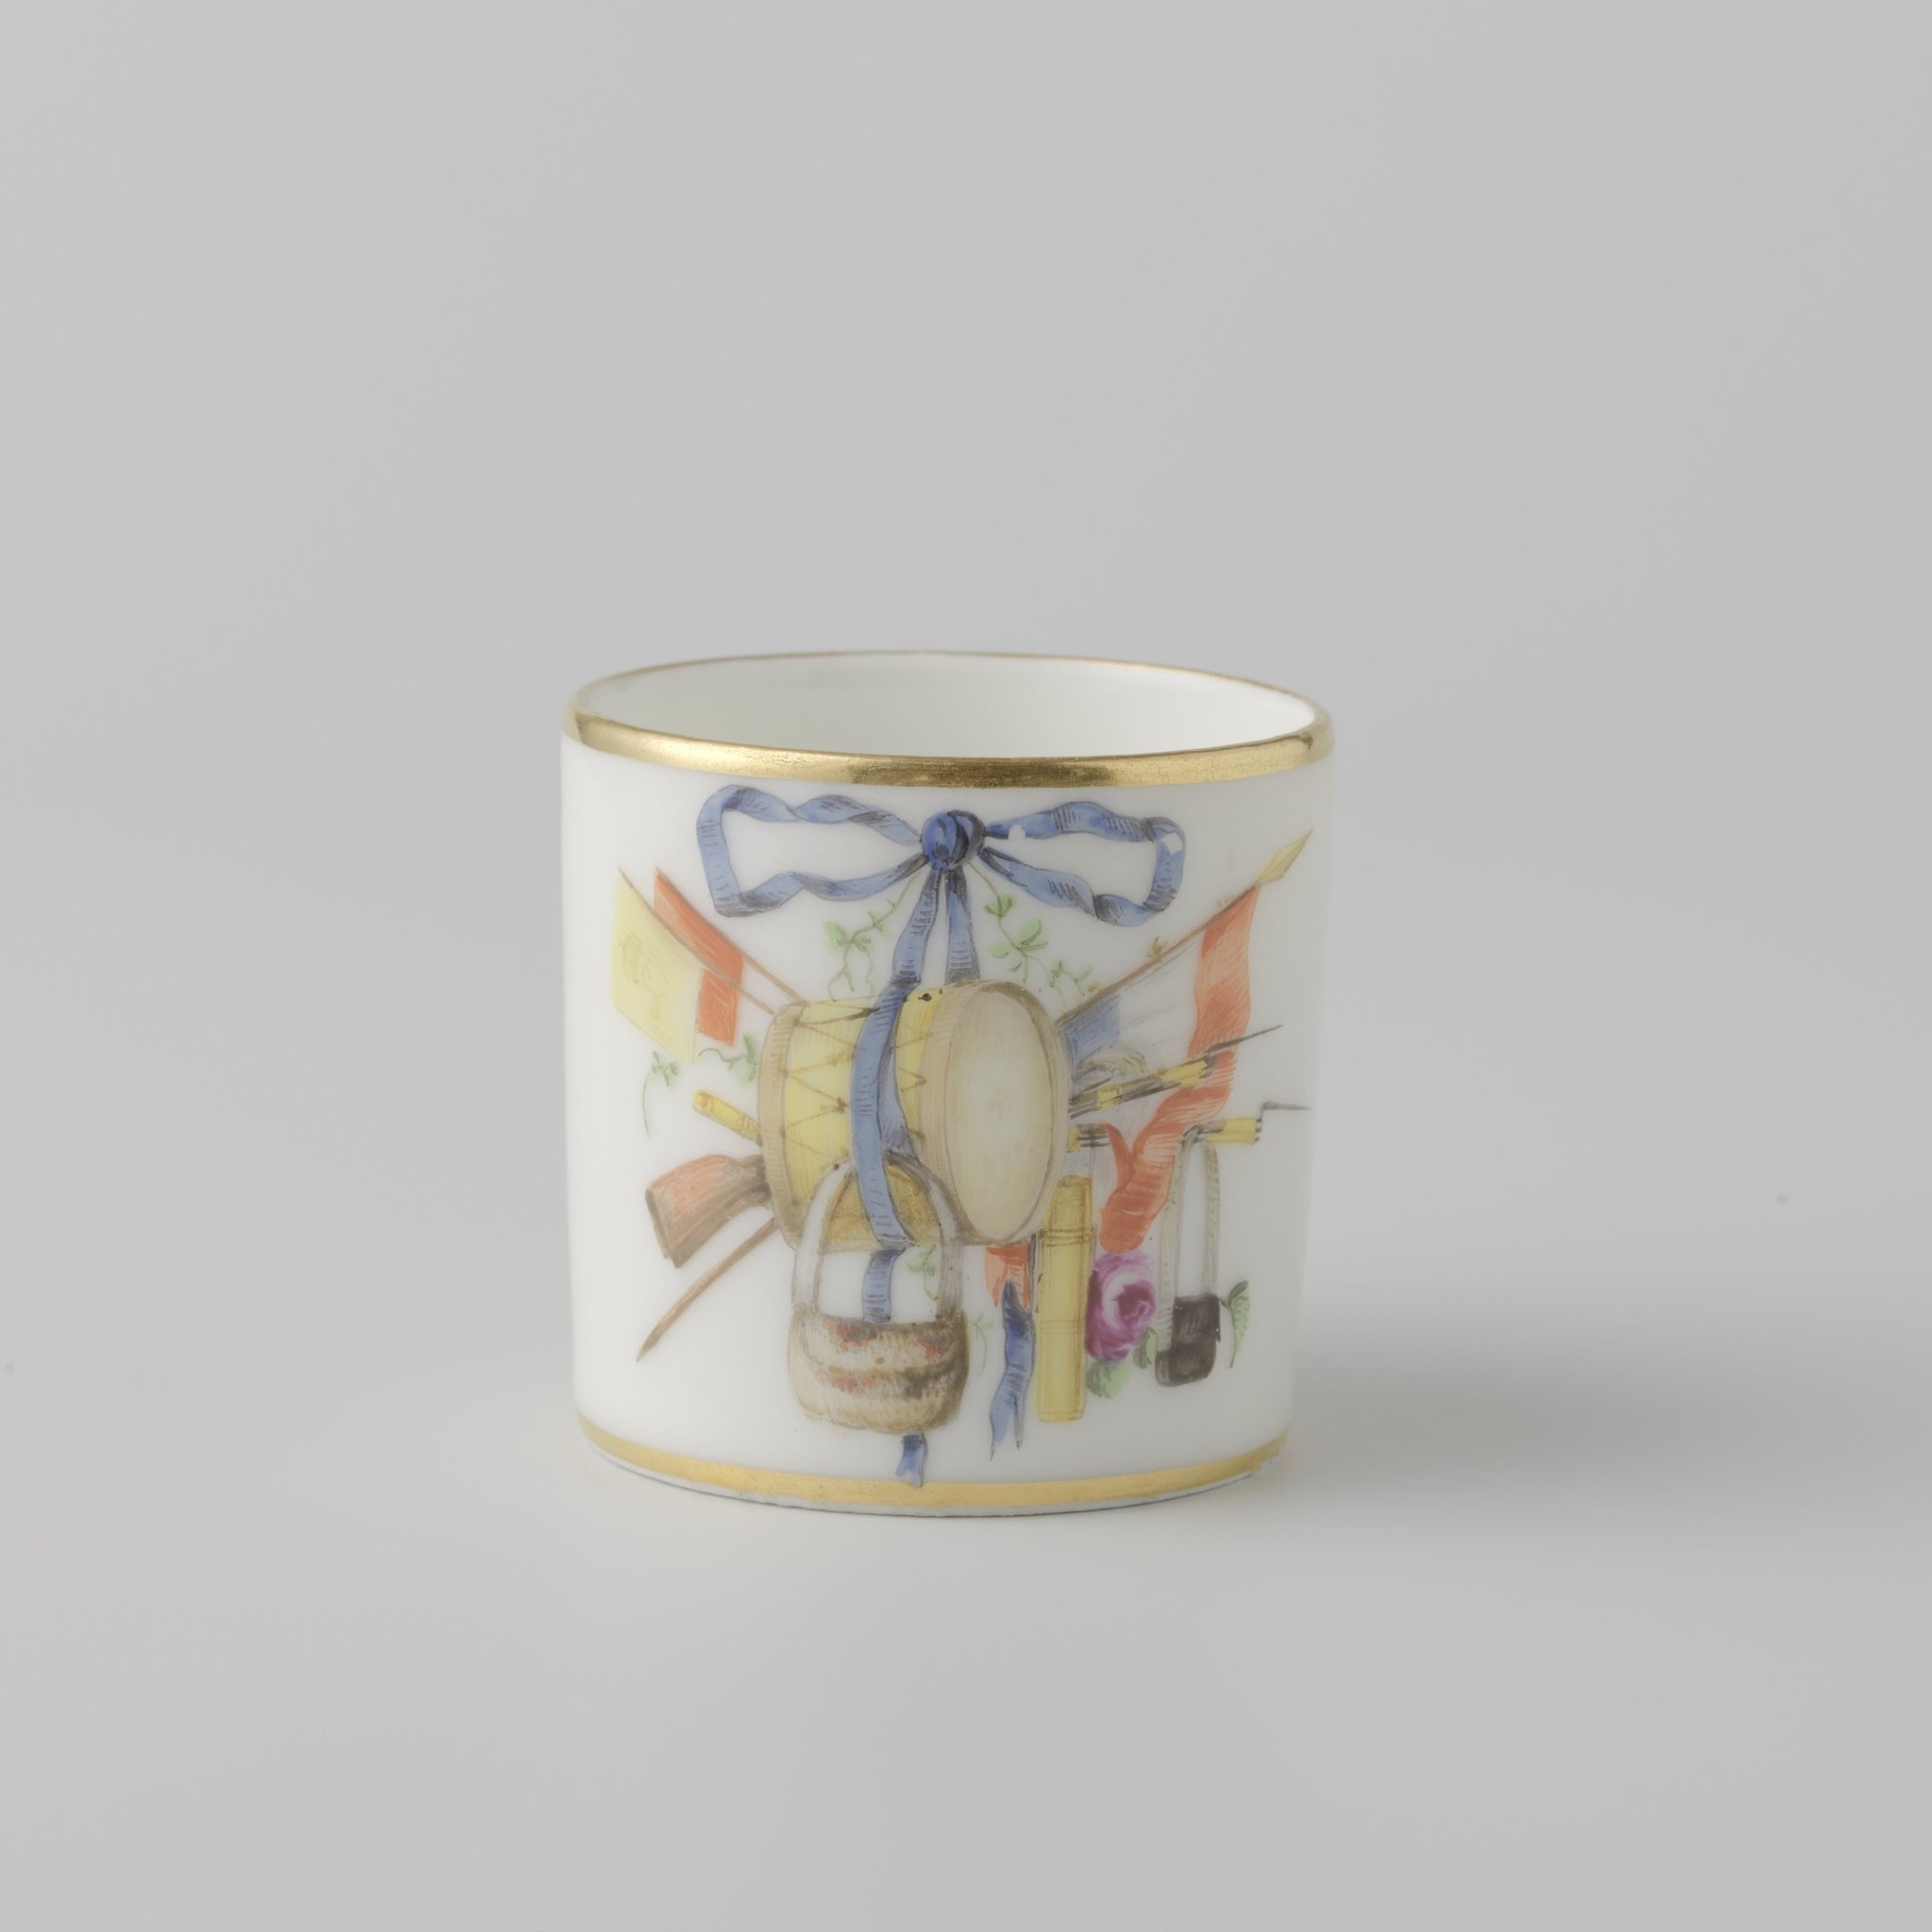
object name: cup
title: Theekop met decoratie van trofeeën aan gestrikte linten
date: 1809-1814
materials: porcelain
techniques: painted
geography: nieuwer-amstel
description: Theeservies bestaande uit een theepot, een suikerpot, een spoelkom en twaalf koppen en schotels veelkleurig beschilderd met trofeeën hangend aan blauwe strikken. De trofeeën hebben betrekking op diverse beroepen. Gemerkt in zwart: Amstel (de suikerpot Amstel N. 805 en ingegrift A). Verschillende ingegrifte merken in de koppen en schotels.